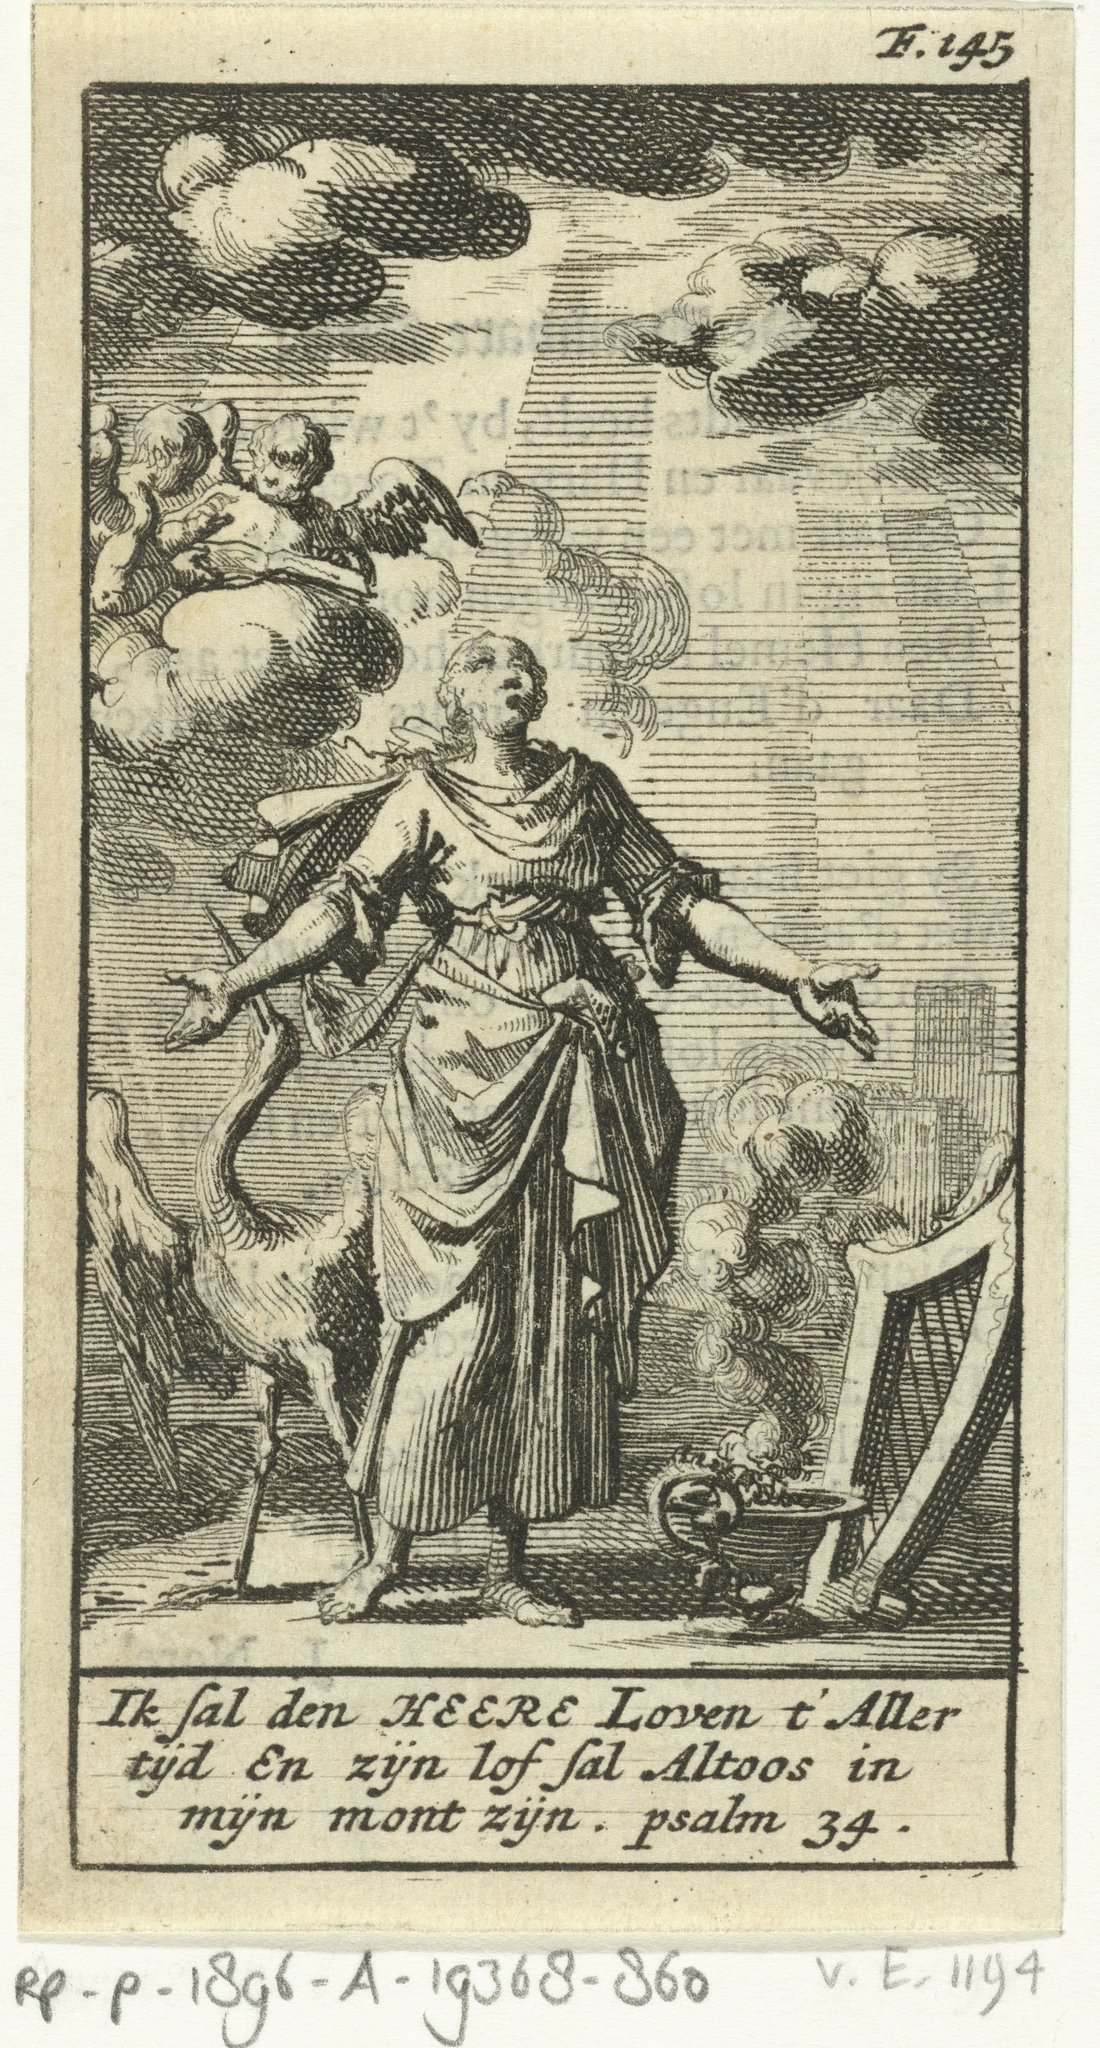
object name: print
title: Vrouw met gespreide armen door hemellicht beschenen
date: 1691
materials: paper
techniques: etching, letterpress printing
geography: amsterdam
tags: light shining out of the heavens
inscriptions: collector's mark: Lugt 2228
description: Illustratie uit: Hakvoord, Barend. Het heilige avondmaal, van onzen Heer en Zaligmaker Jesus Christus. Amsterdam: Gijsbert de Groot, 1691.